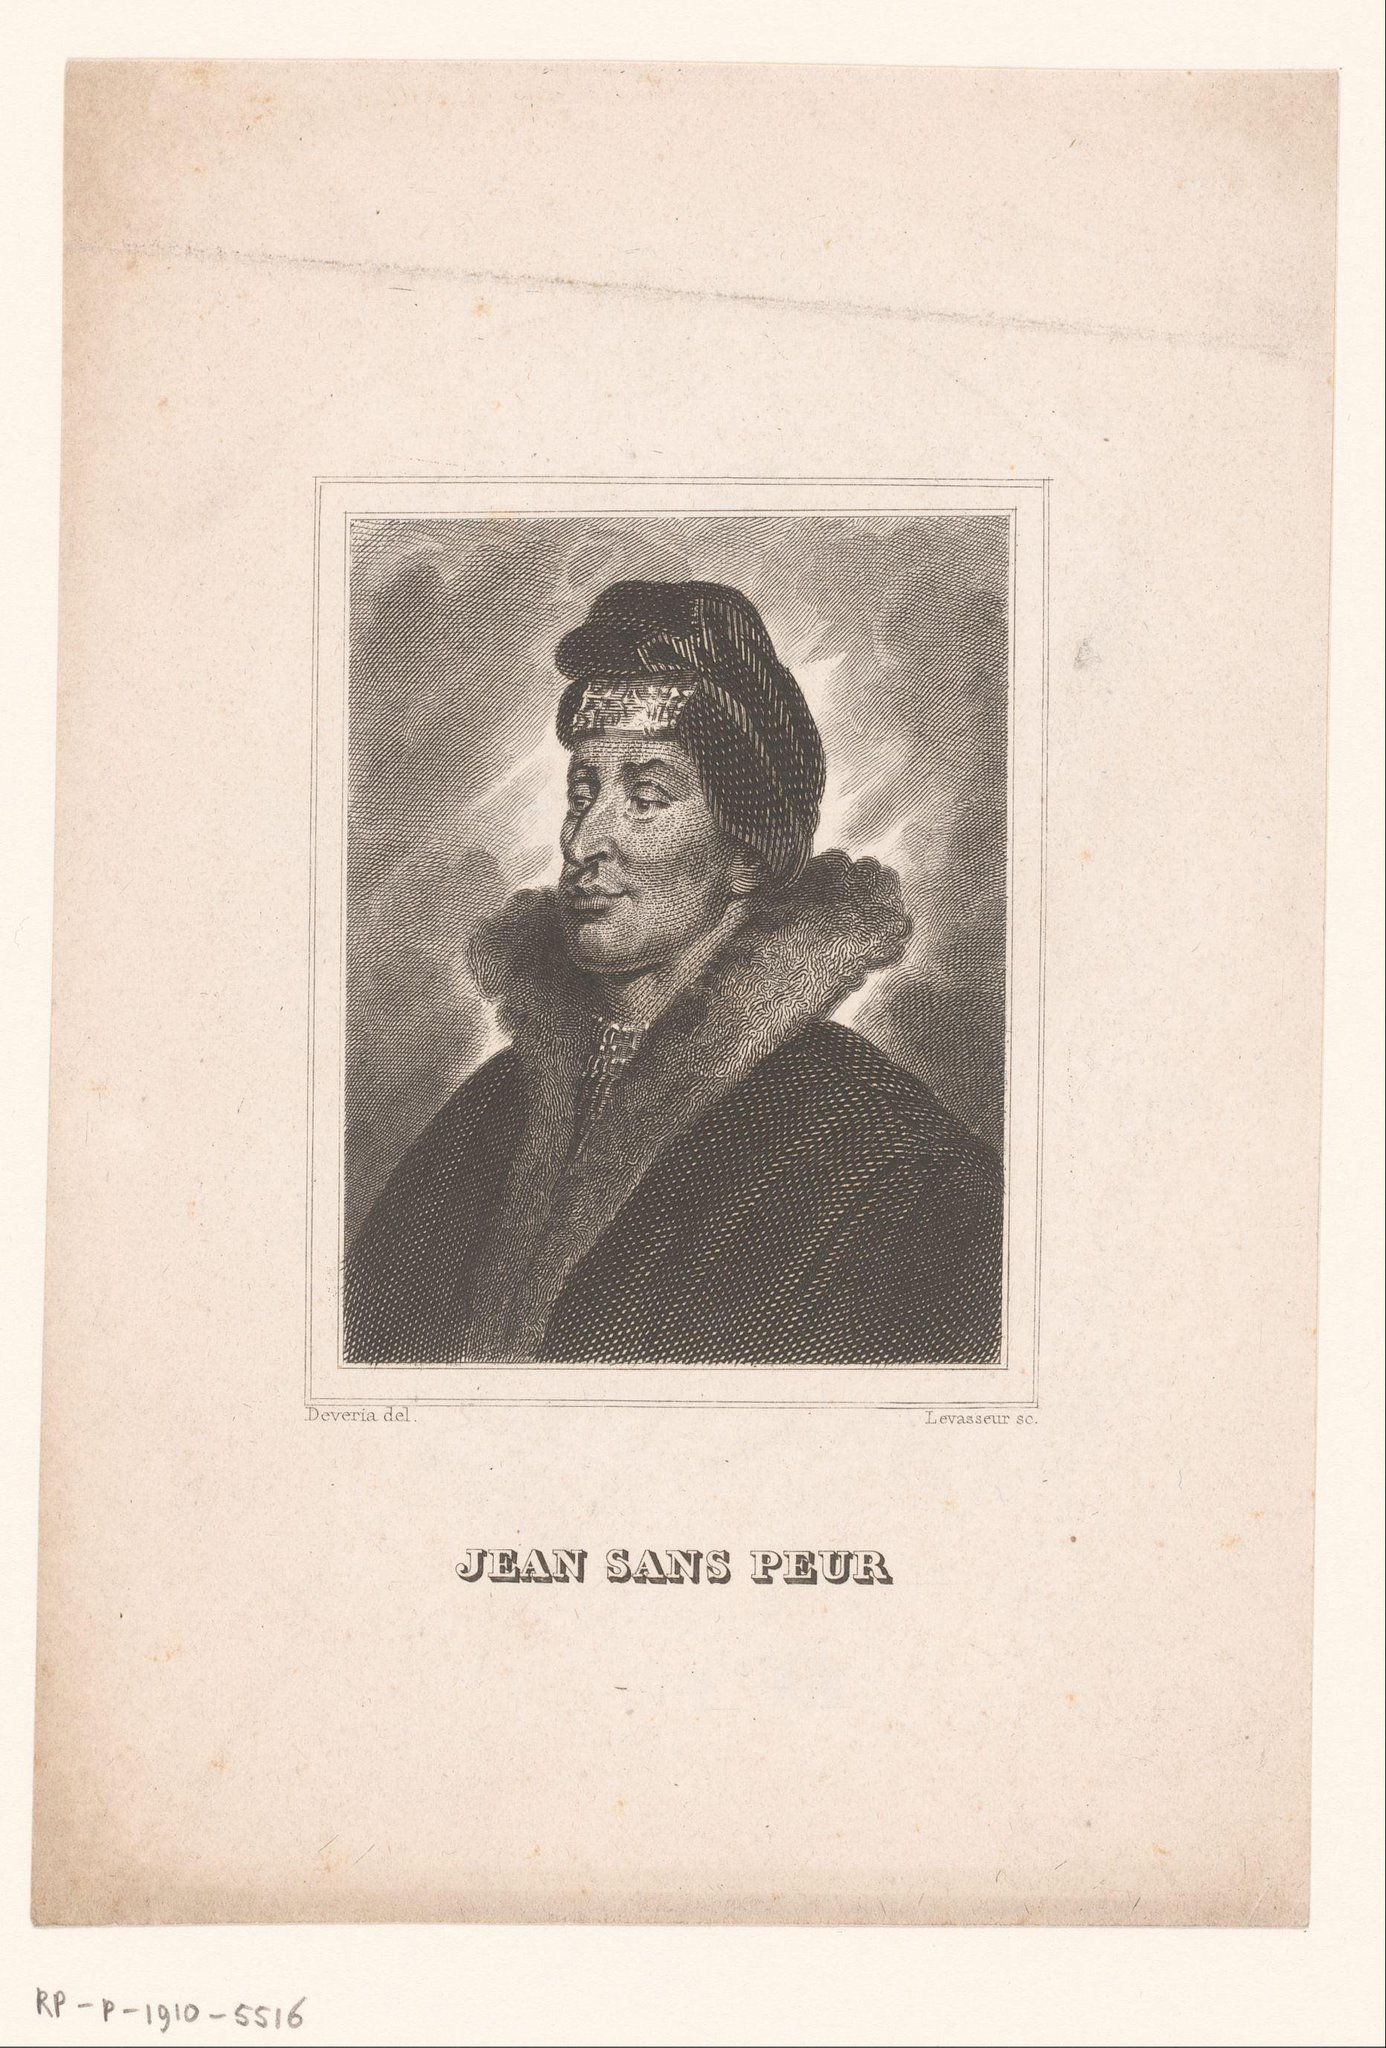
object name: print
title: Jean sans Peur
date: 1825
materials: paper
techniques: engraving, etching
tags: historical persons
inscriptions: collector's mark: Lugt 2228